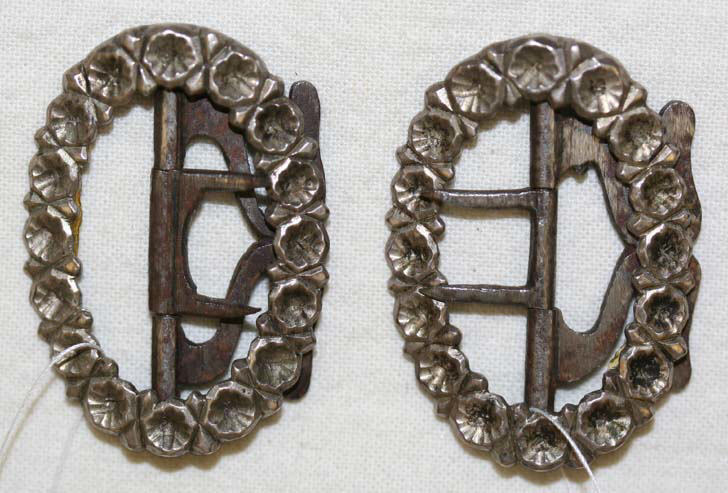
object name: buckle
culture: european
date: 1767-1800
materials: metal